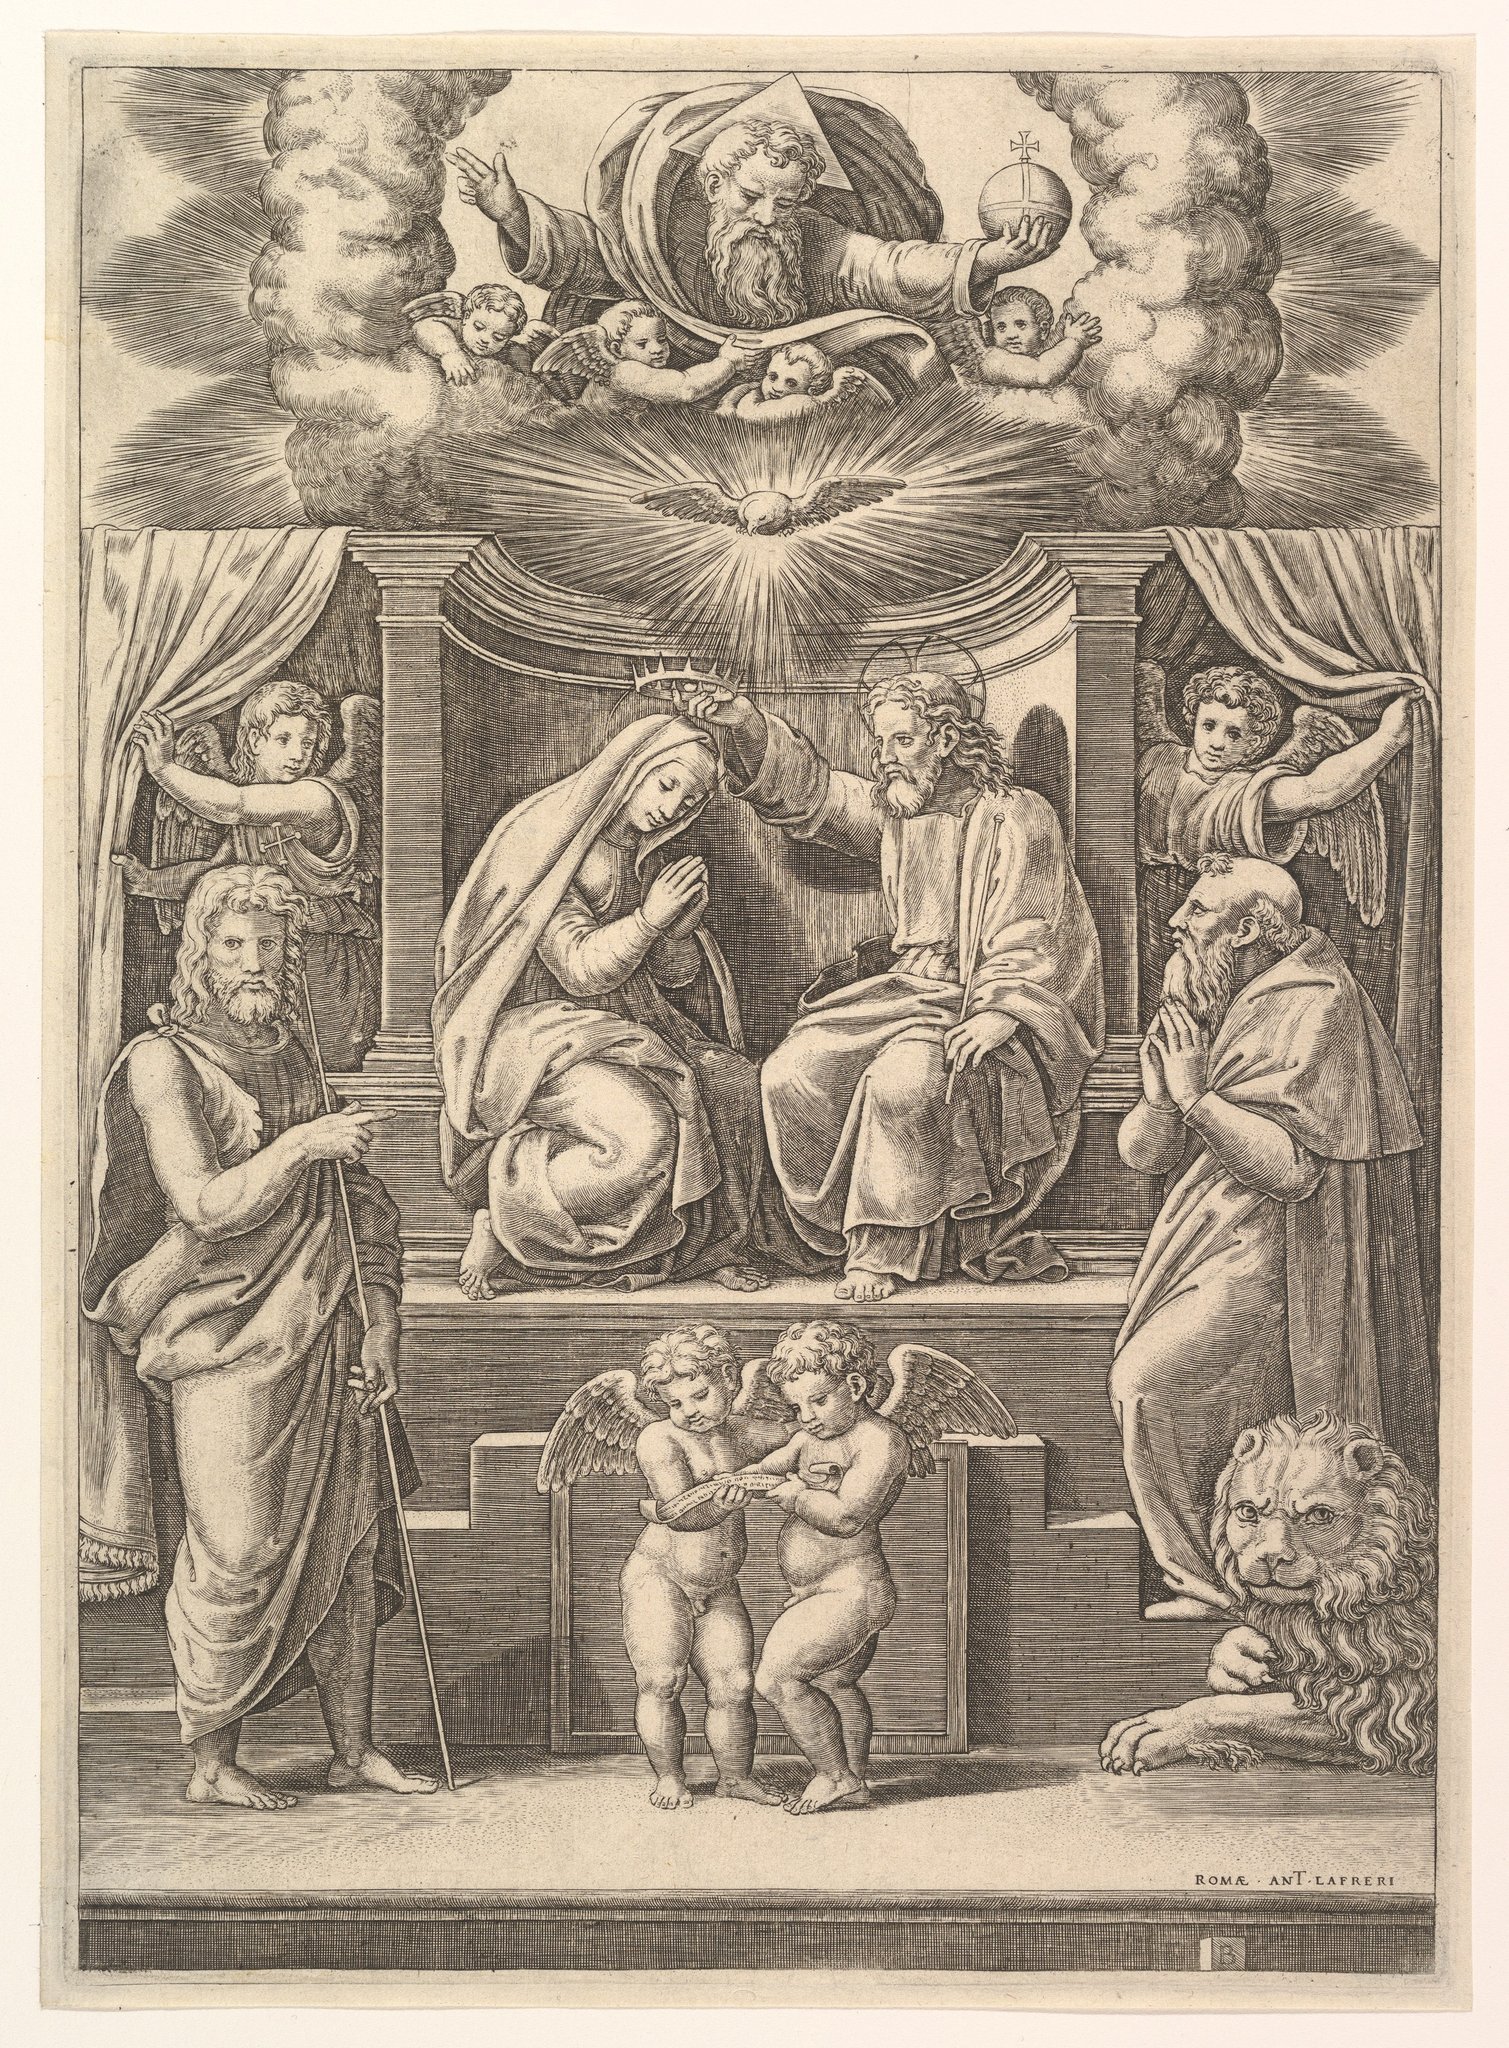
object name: print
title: The coronation of the Virgin, God the Father above, St Jerome lower right and St John the Baptist lower left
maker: master of the die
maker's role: artist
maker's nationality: italian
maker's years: 1525-1560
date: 1530-1560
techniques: engraving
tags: angels,saint jerome,saint john the baptist,virgin mary